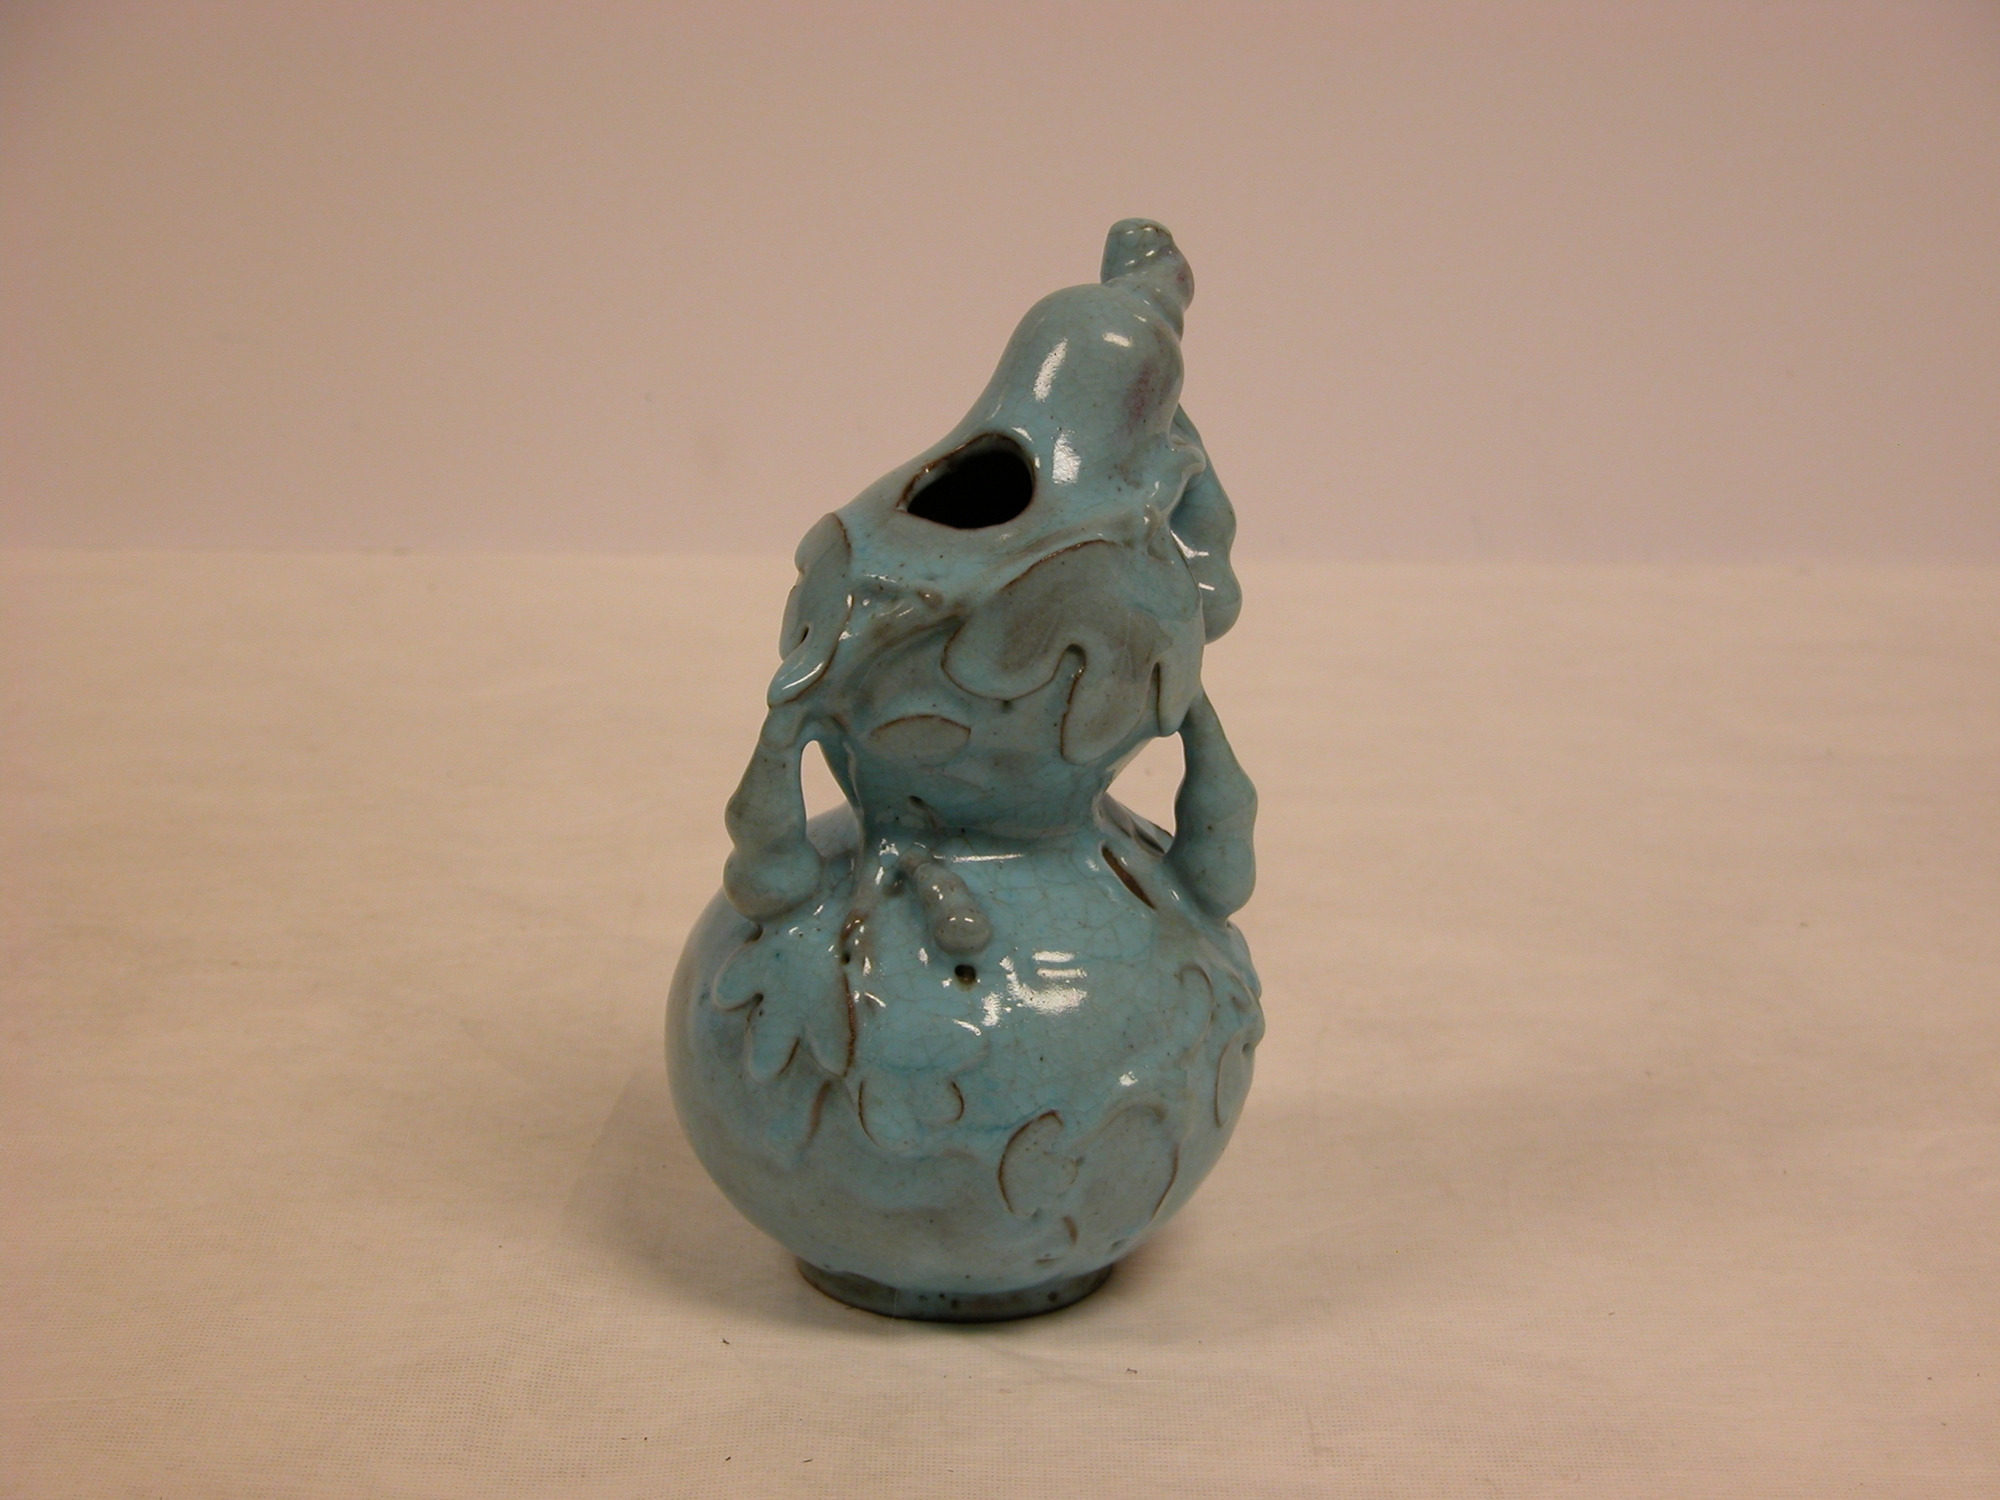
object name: vase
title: Vase in the shape of a double gourd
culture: chinese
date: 960-1279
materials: pottery